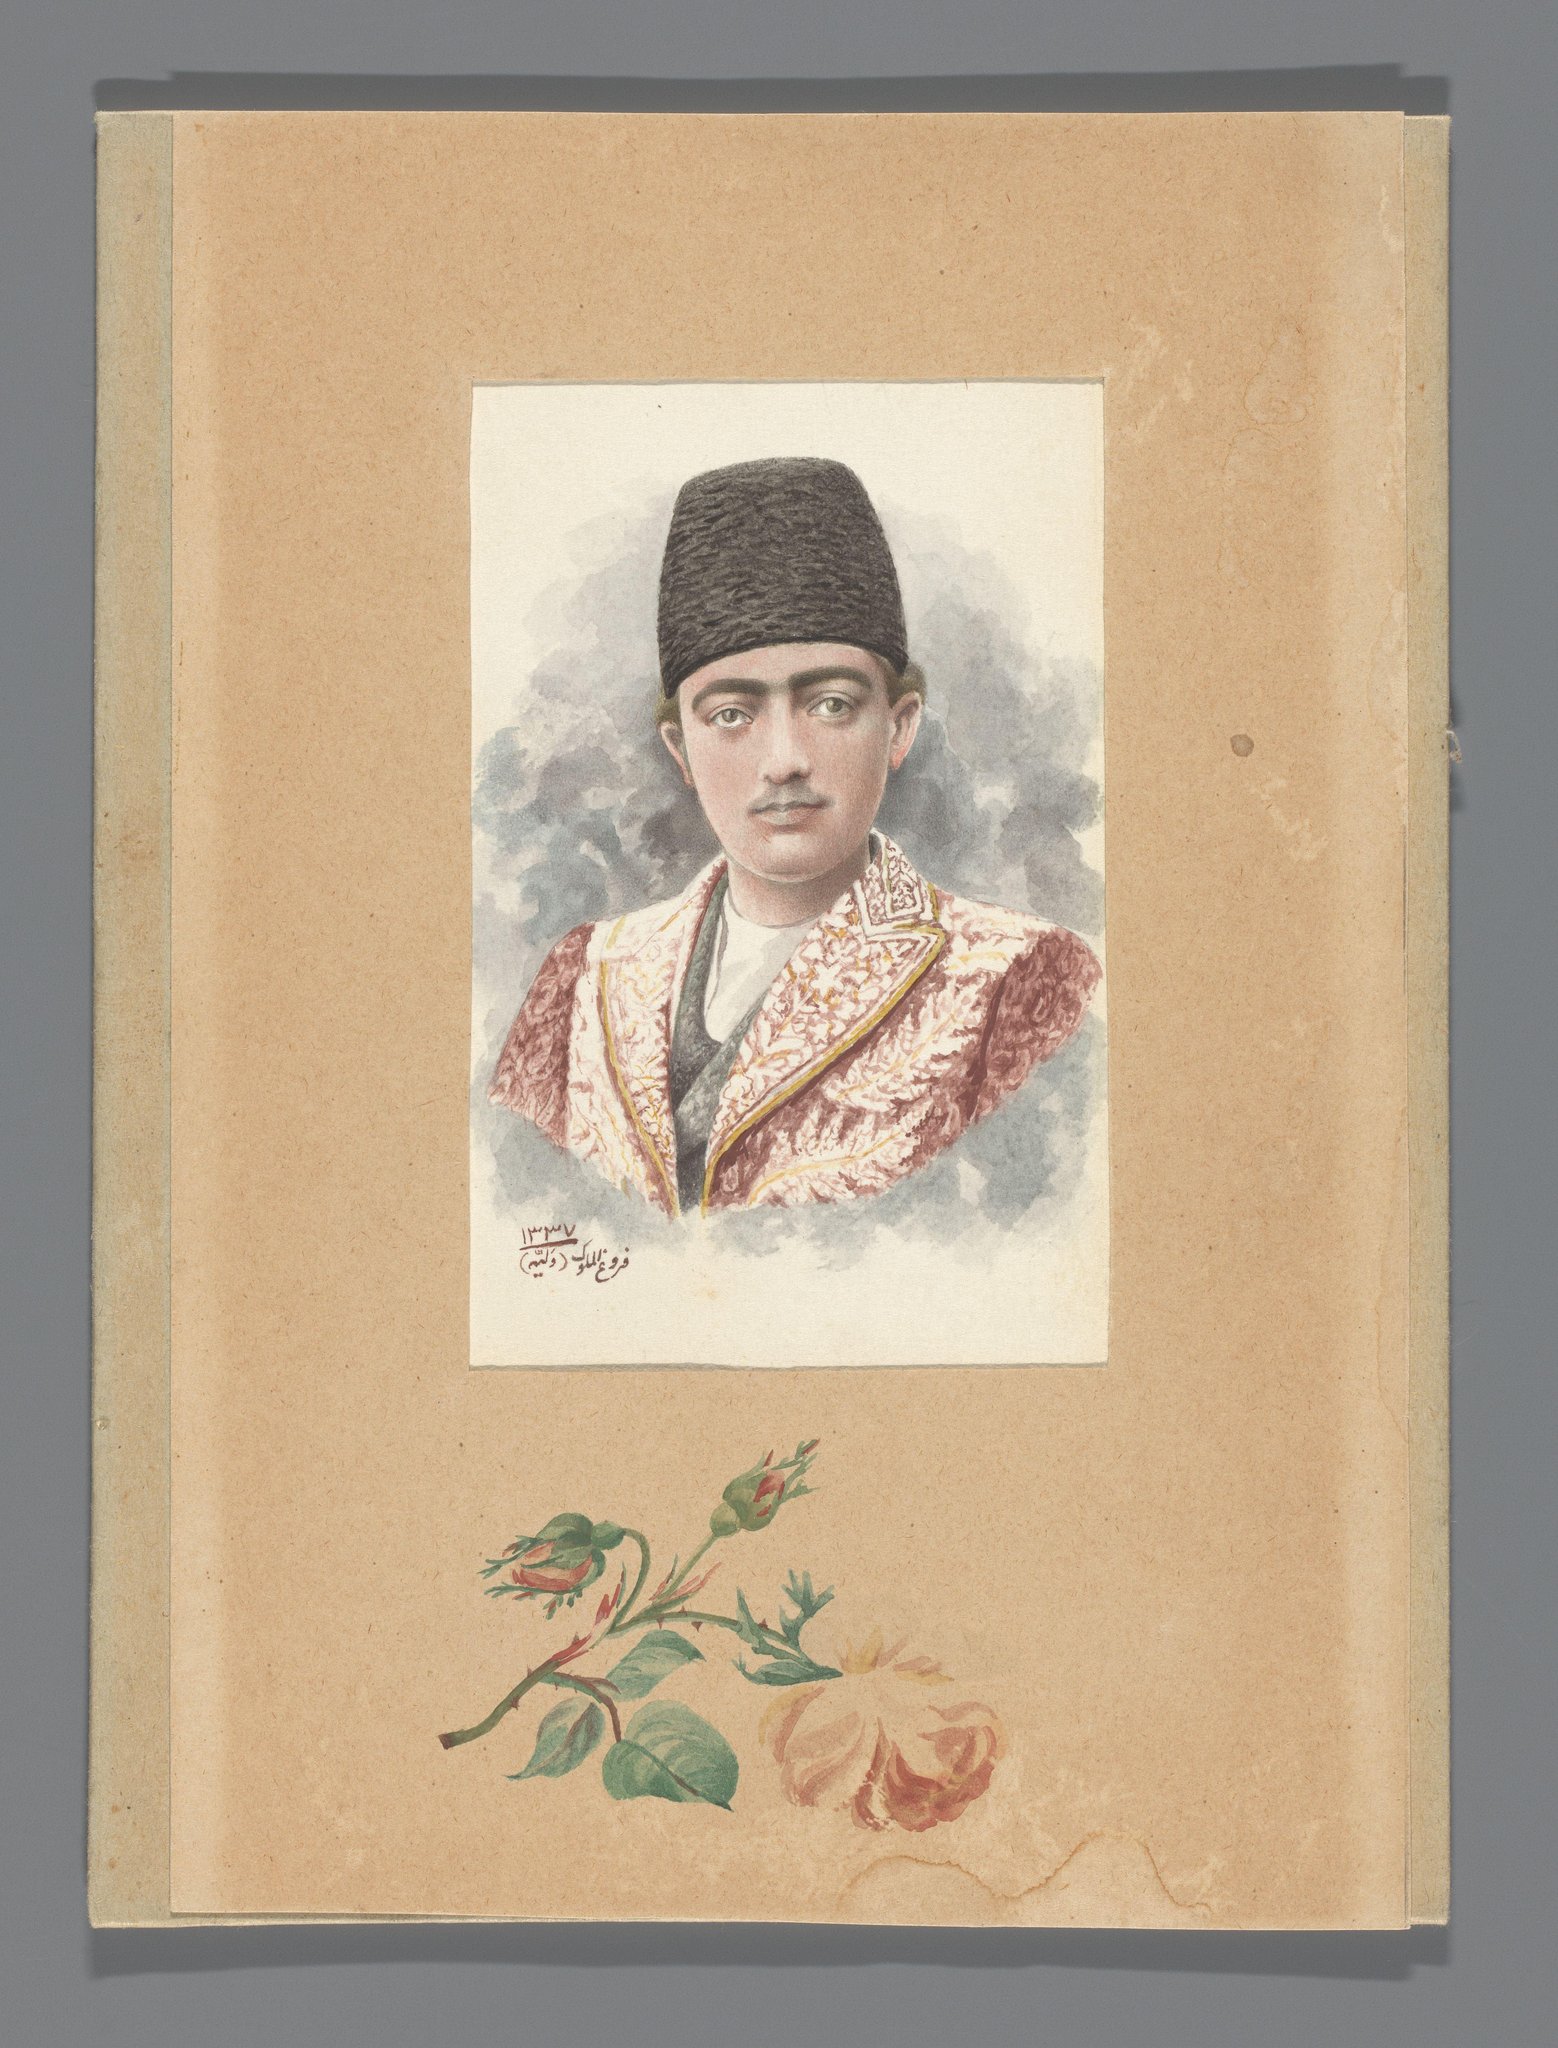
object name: photograph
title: Portret van Tavakoli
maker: Anonymous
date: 1900-1950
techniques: aquarelle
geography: iran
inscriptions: inscription: ‘Opschriften in farsi’